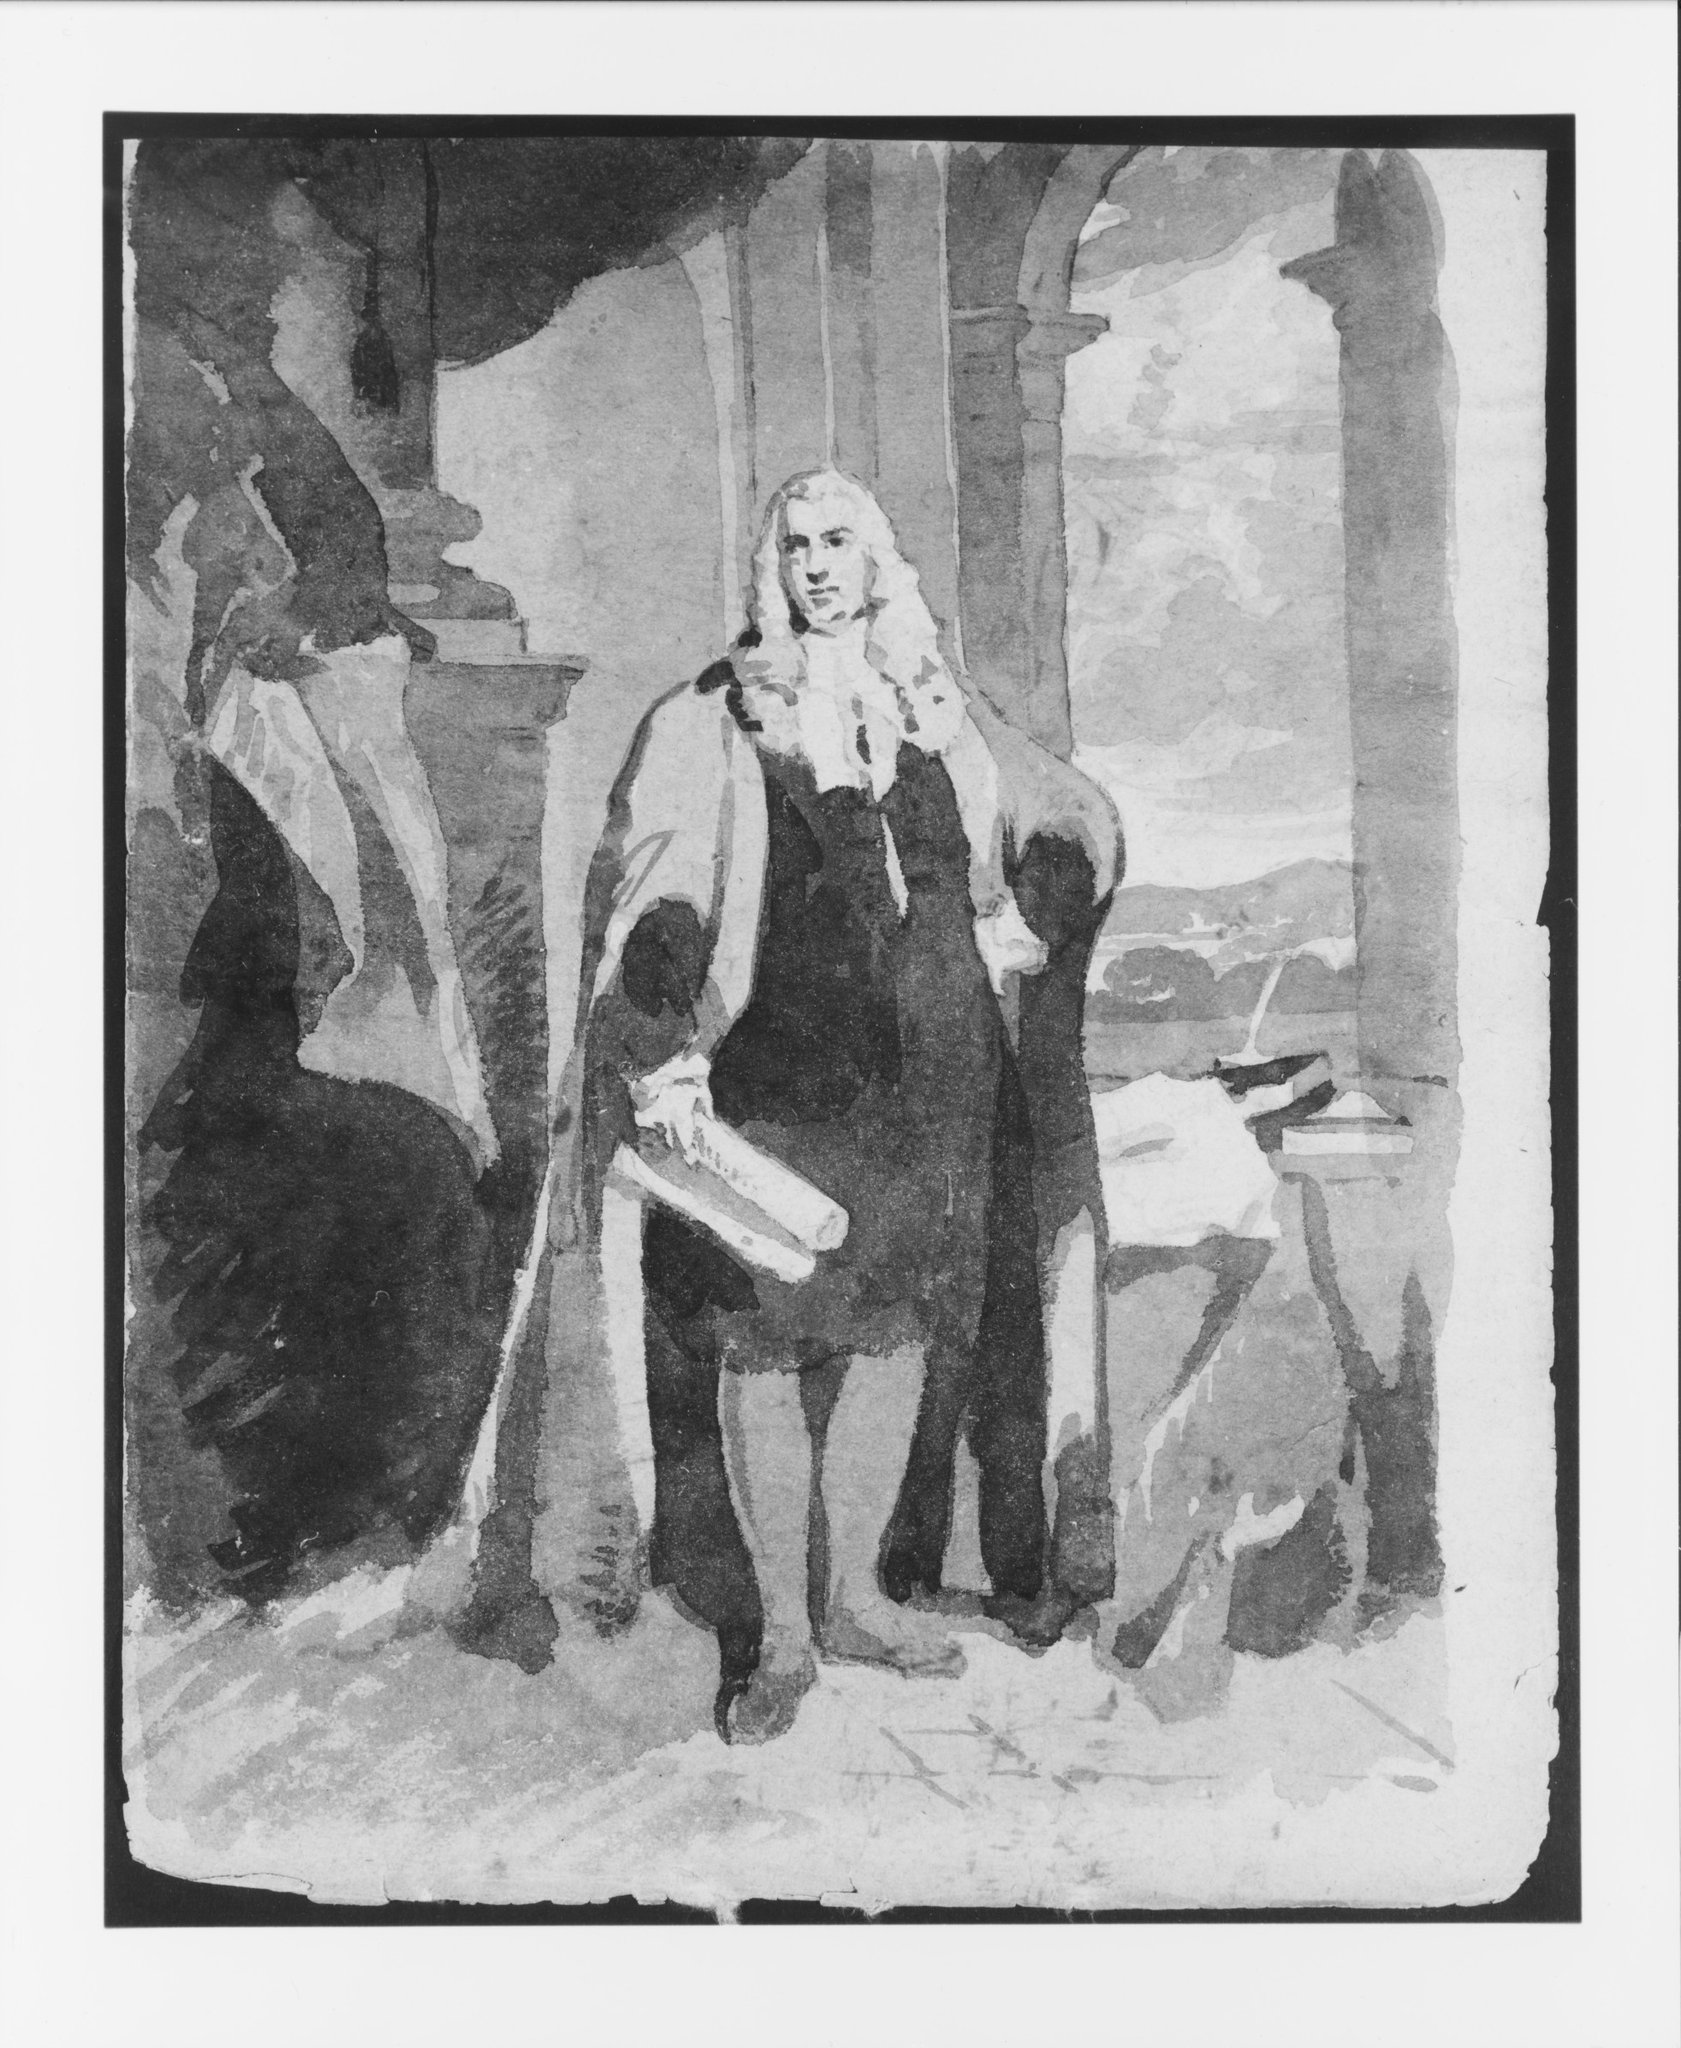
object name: drawing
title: Standing Man, with Scroll (from Sketchbook)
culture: american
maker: thomas sully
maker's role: artist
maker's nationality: american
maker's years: 1783-1872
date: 1810-1820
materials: ink, paper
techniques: wash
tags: scrolls,men